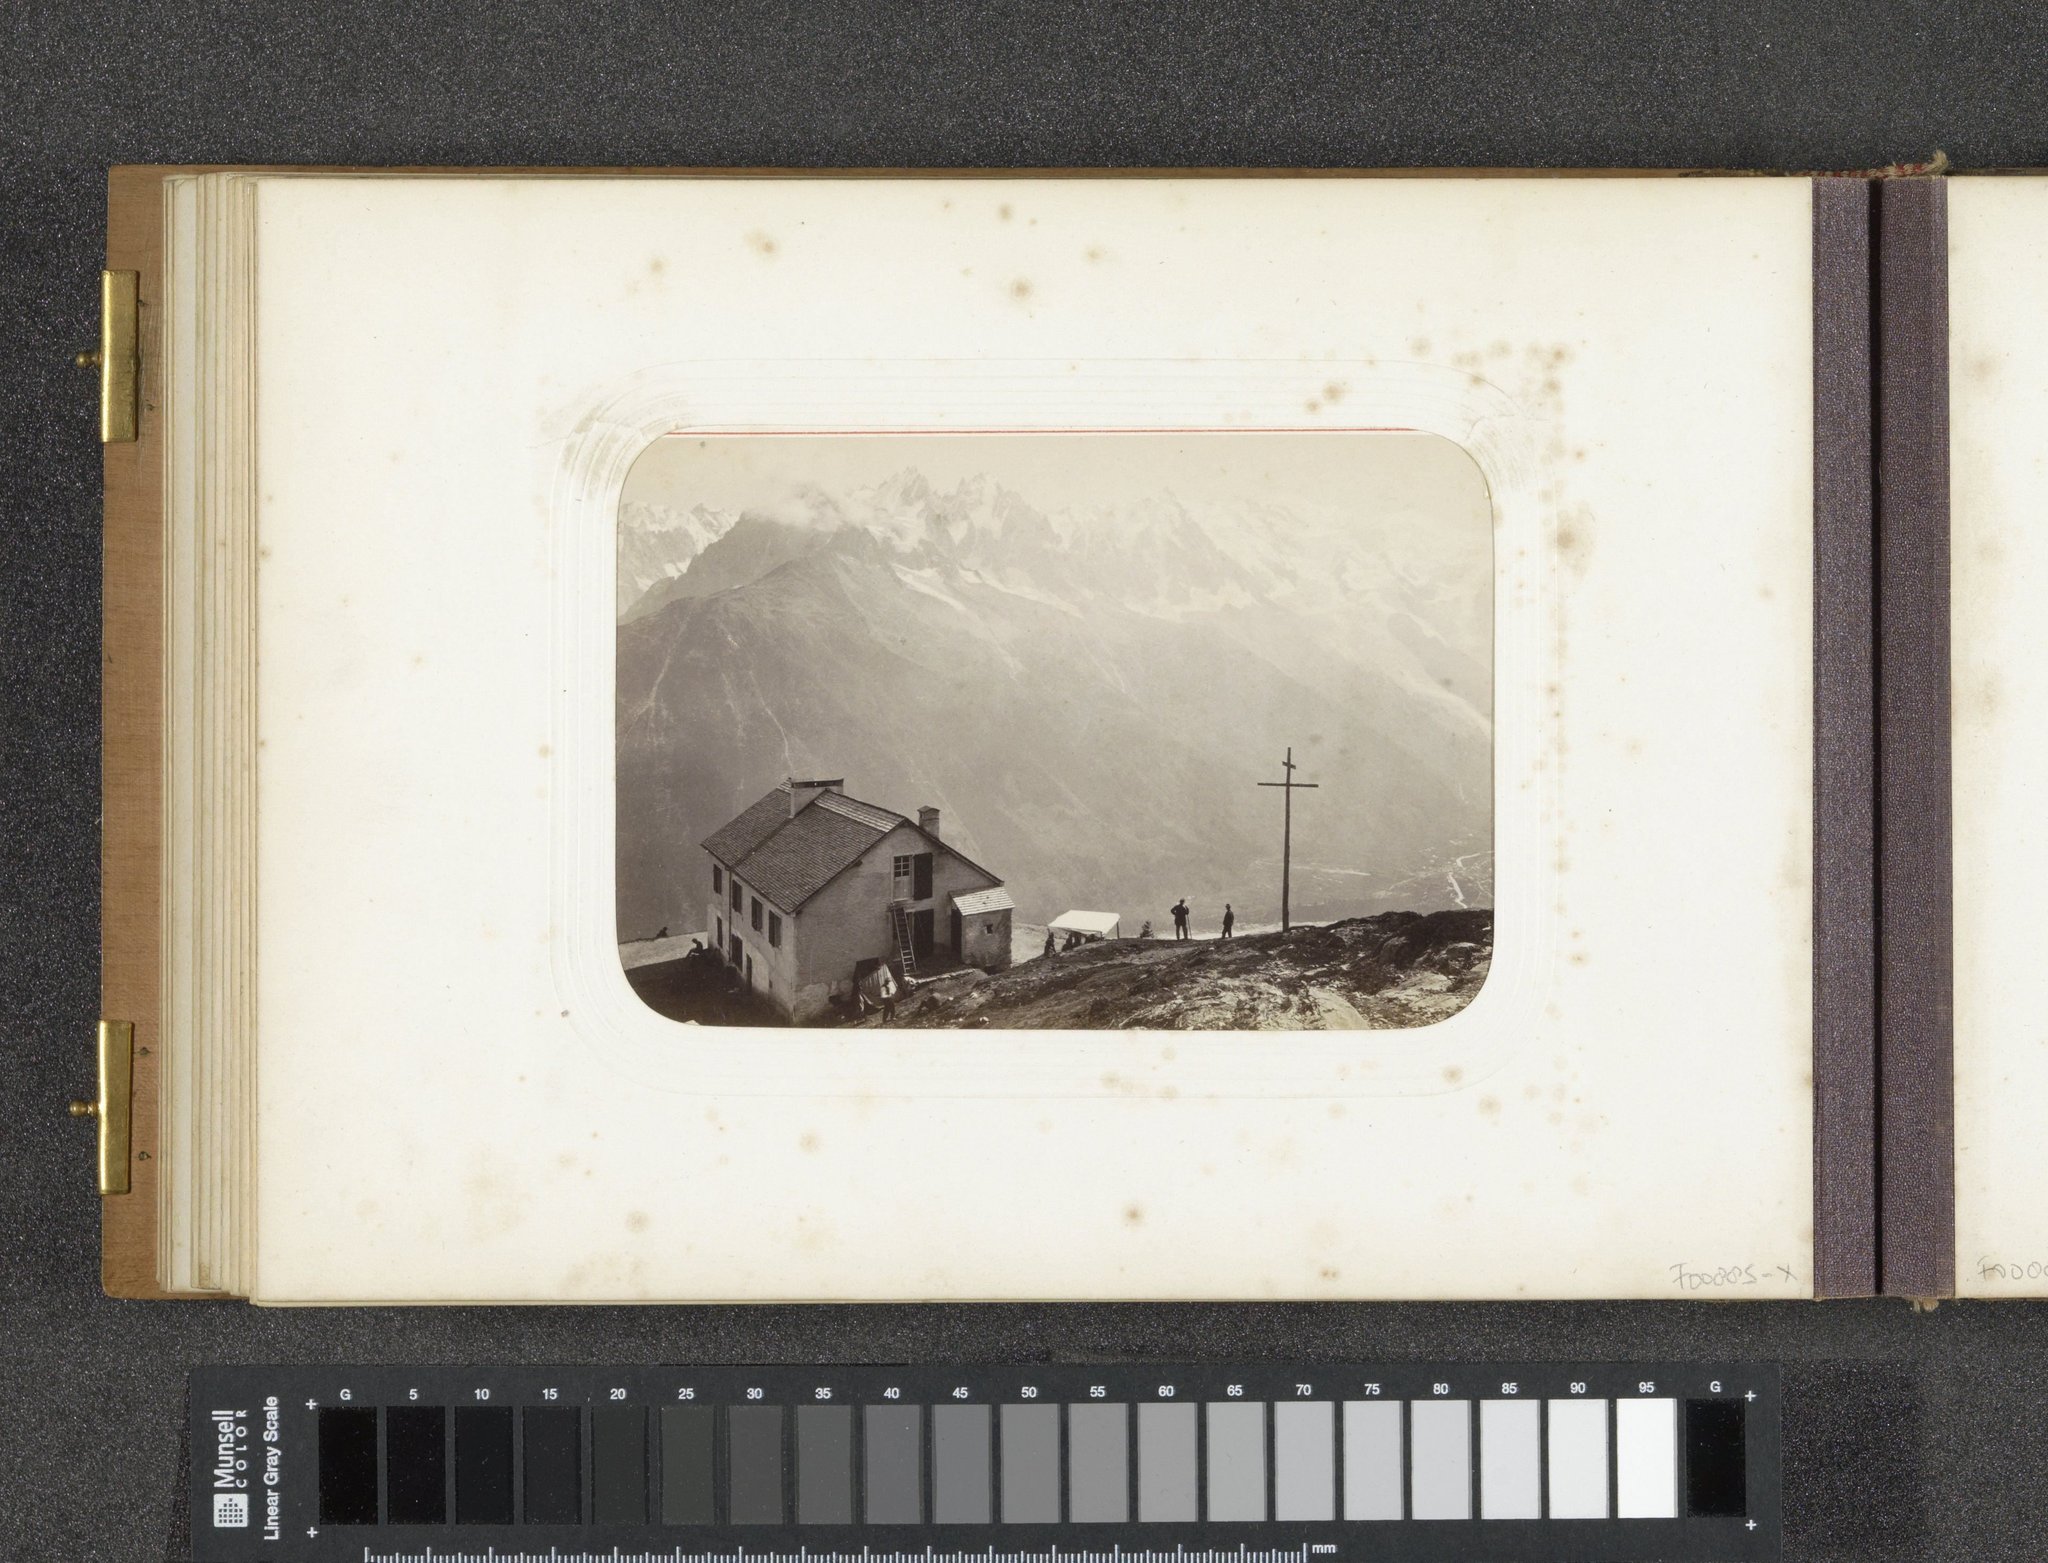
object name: album leaf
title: Mont Blanc gezien vanaf La Flégère met op de voorgrond herberg Au Repos des Voyageurs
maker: auguste garcin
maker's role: fotograaf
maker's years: 1816-1895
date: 1860-1880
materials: cardboard, paper, photographic support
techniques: albumen print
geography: alps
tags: mountains (+ landscape with figures, staffage), restaurant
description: Onderdeel van Reisalbum met bezienswaardigheden in de Zwitserse Alpen.